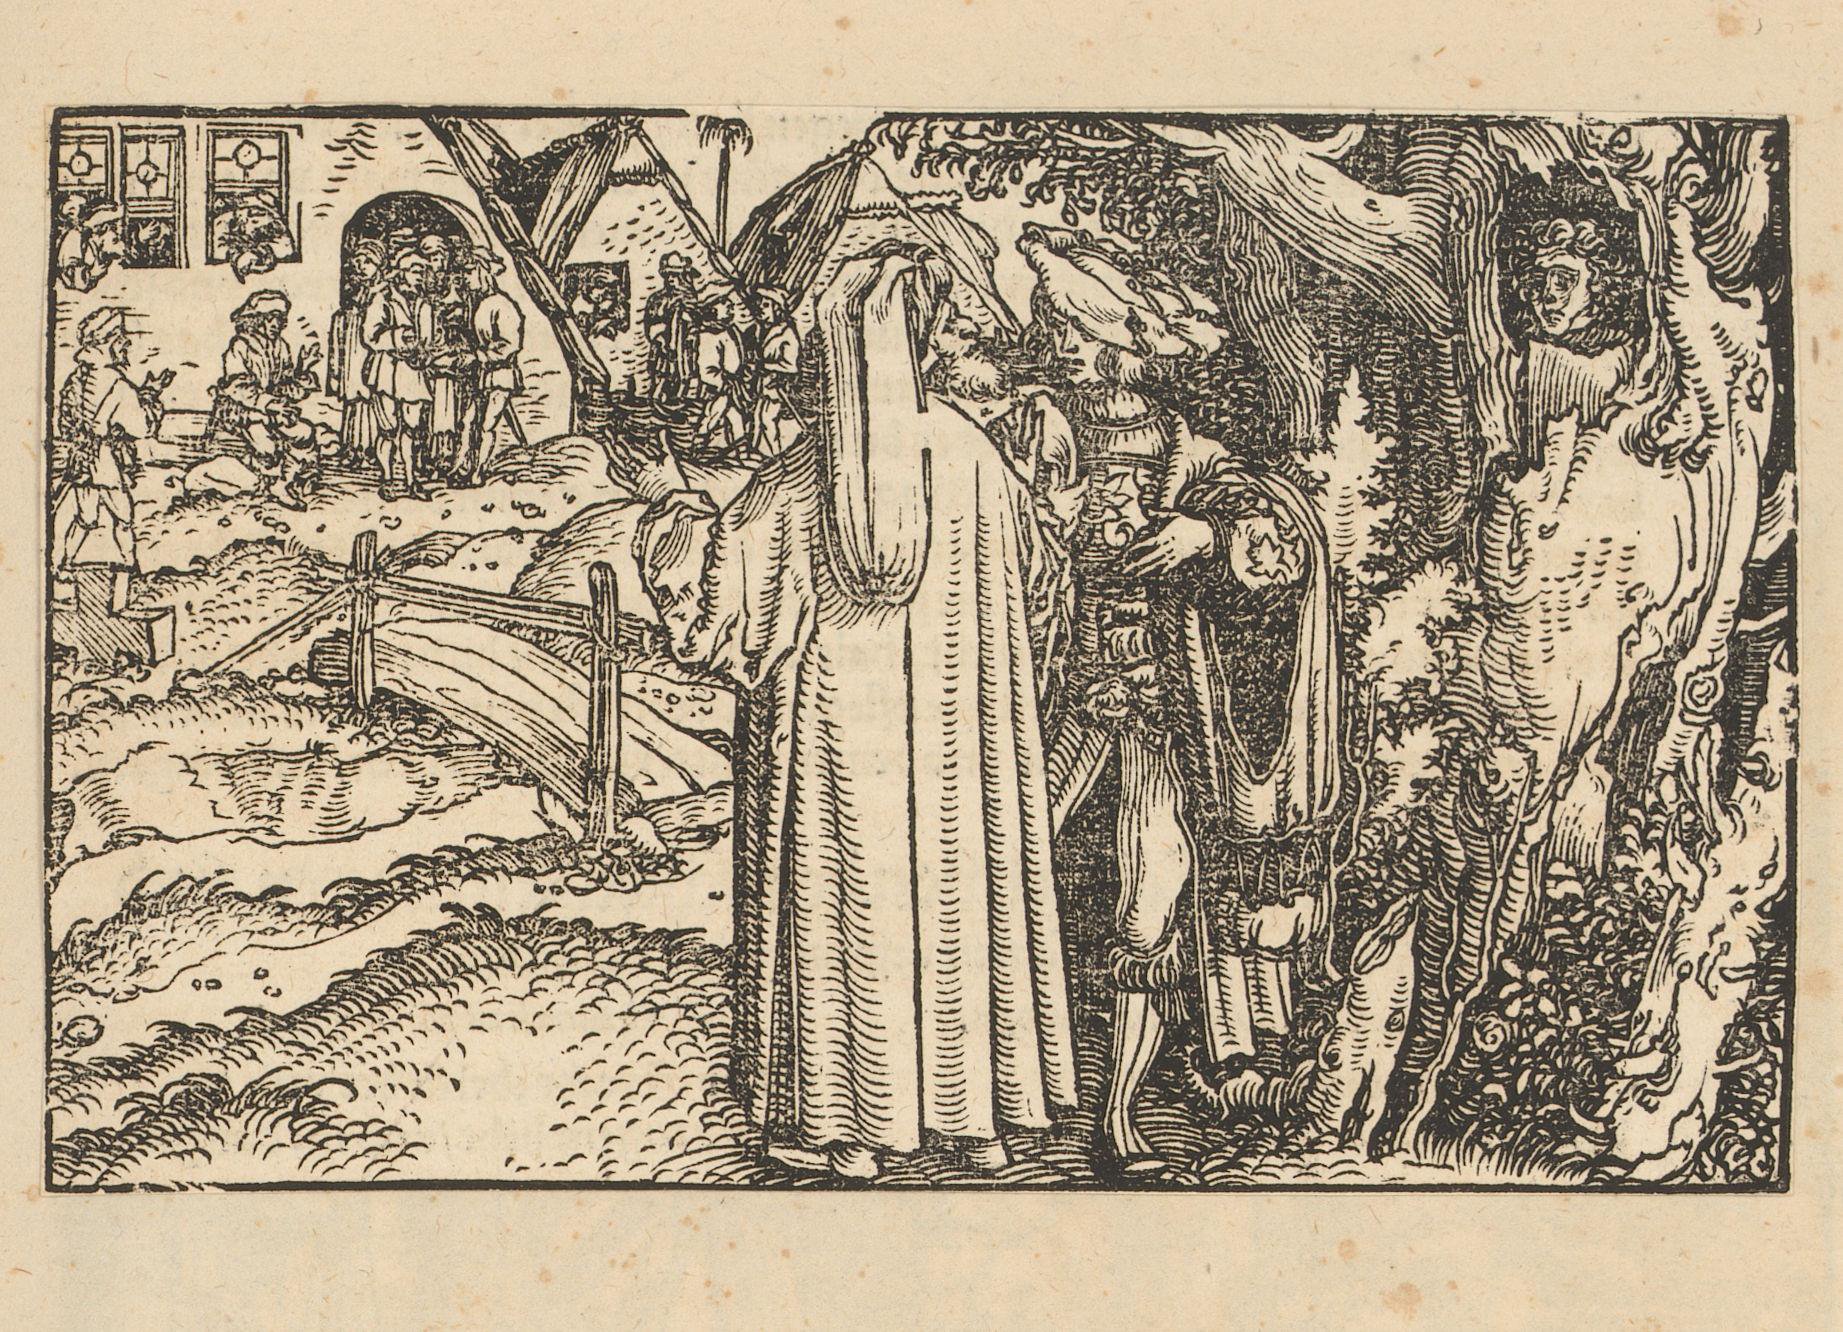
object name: print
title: Twee mannen praten nabij een dorp en een andere man kijkt toe door een boomholte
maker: Anonymous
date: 1514-1532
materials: paper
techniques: letterpress printing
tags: prospect of village, silhouette of village, meeting, assembly, eavesdropper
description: Deze prent is gebruikt in: Petrarca, Francesco. Von der Artzney bayder Glück, des guten und widerwertigen: unnd weß sich ain yeder inn Gelück und Unglück halten sol (...). Augsburg: Heinrich Steiner, 1532. Deze uitgave is ook bekend onder de titel 'Trostspiegel in Glück und Unglück'.